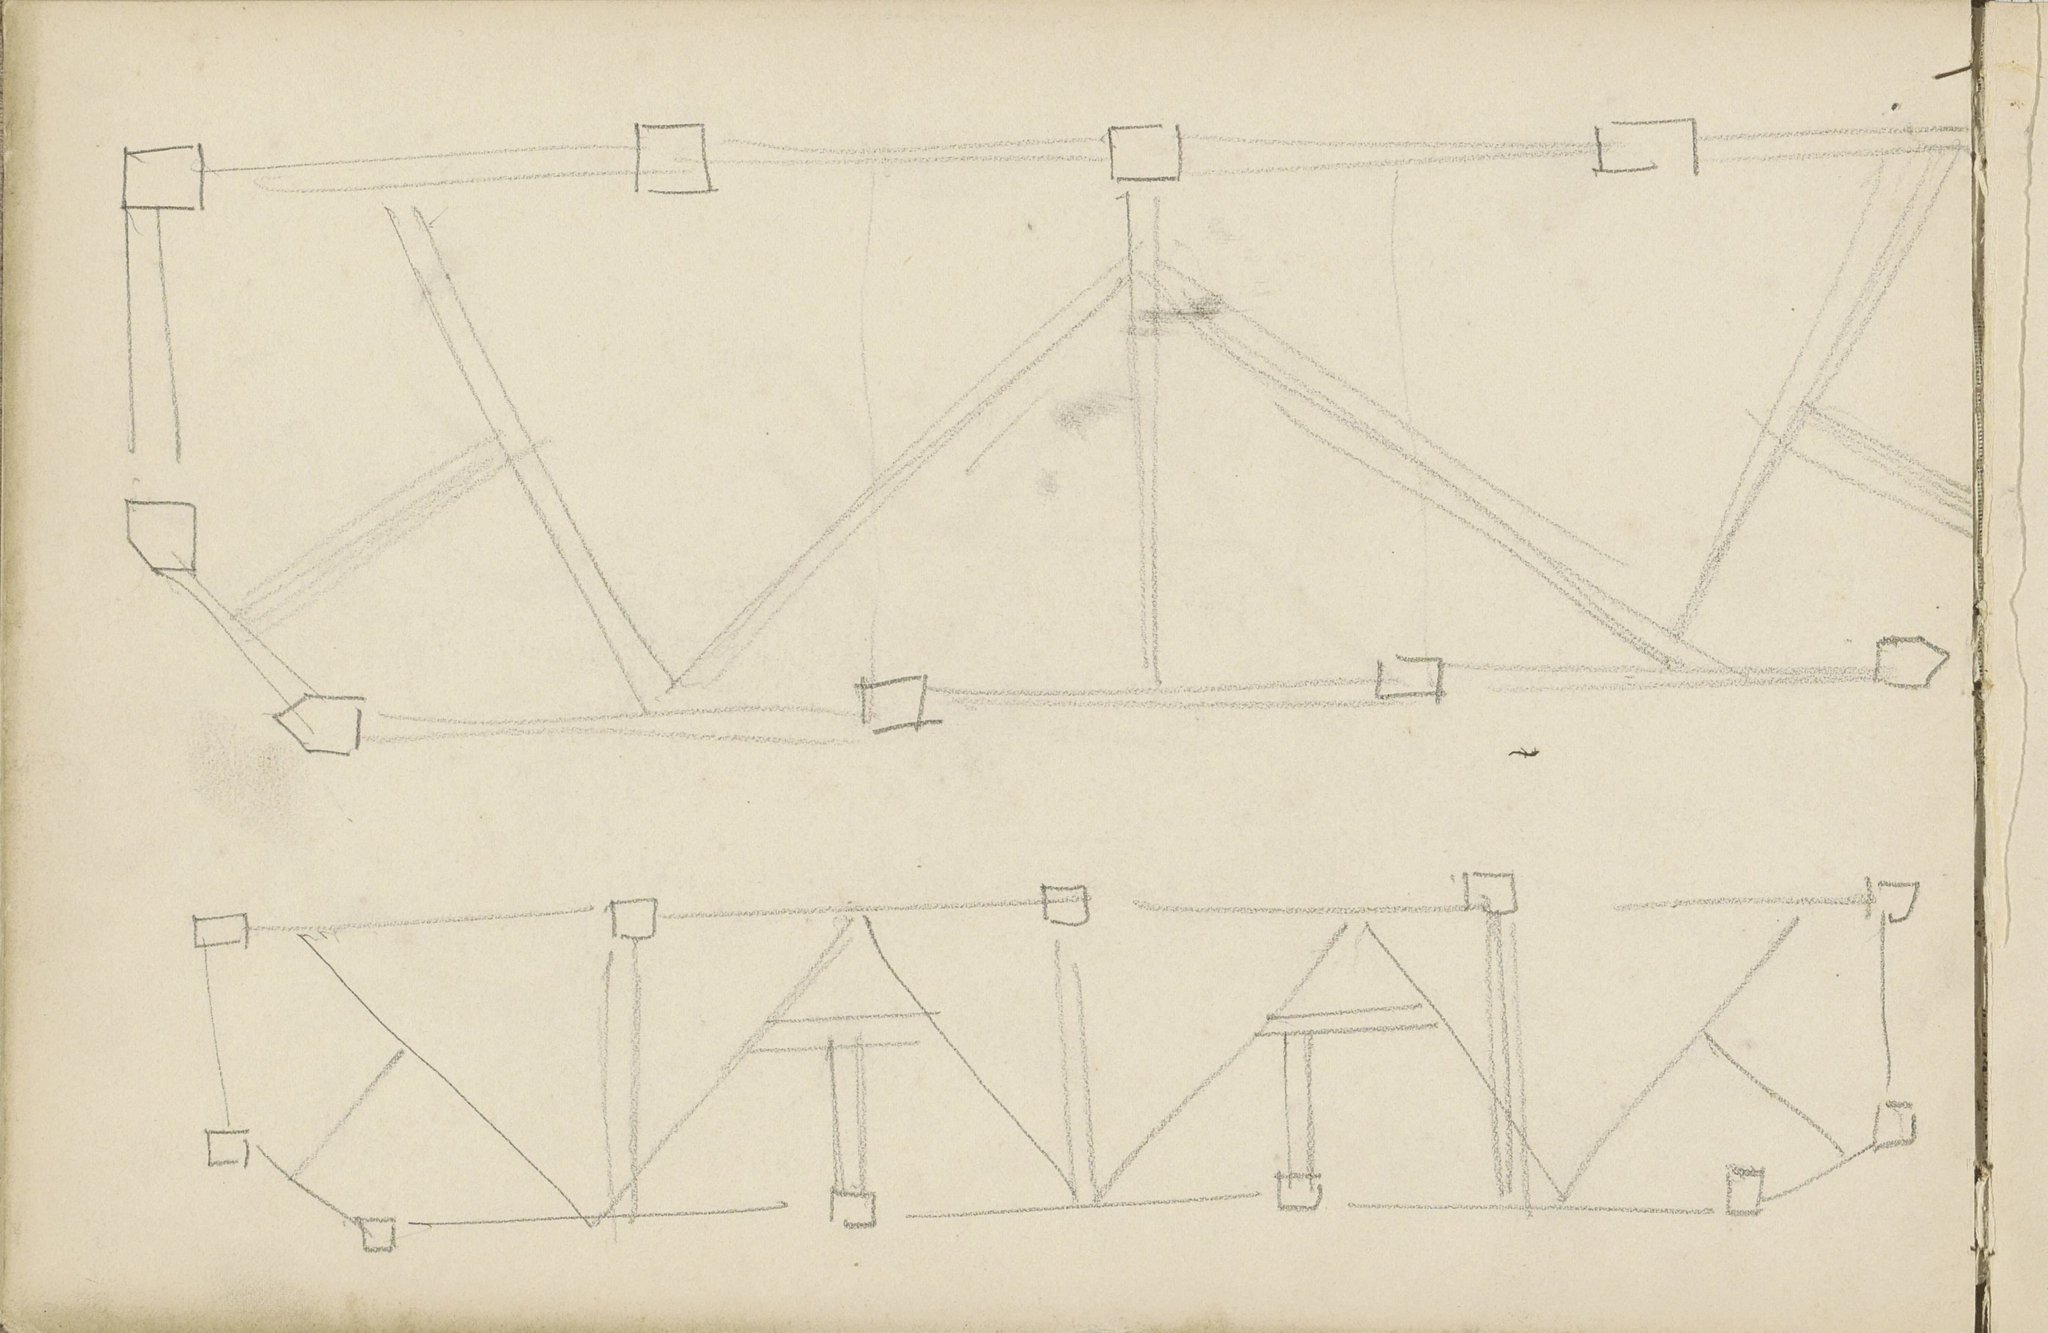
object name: sketchbook leaf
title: Decoratief patroon met vierkanten, rechthoeken en driehoeken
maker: carel adolph lion cachet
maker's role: draughtsman, print maker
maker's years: 1864-1945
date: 1908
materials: paper, pencil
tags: ornament ~ geometric motifs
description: Blad 2 verso uit een schetsboek met 25 bladen.